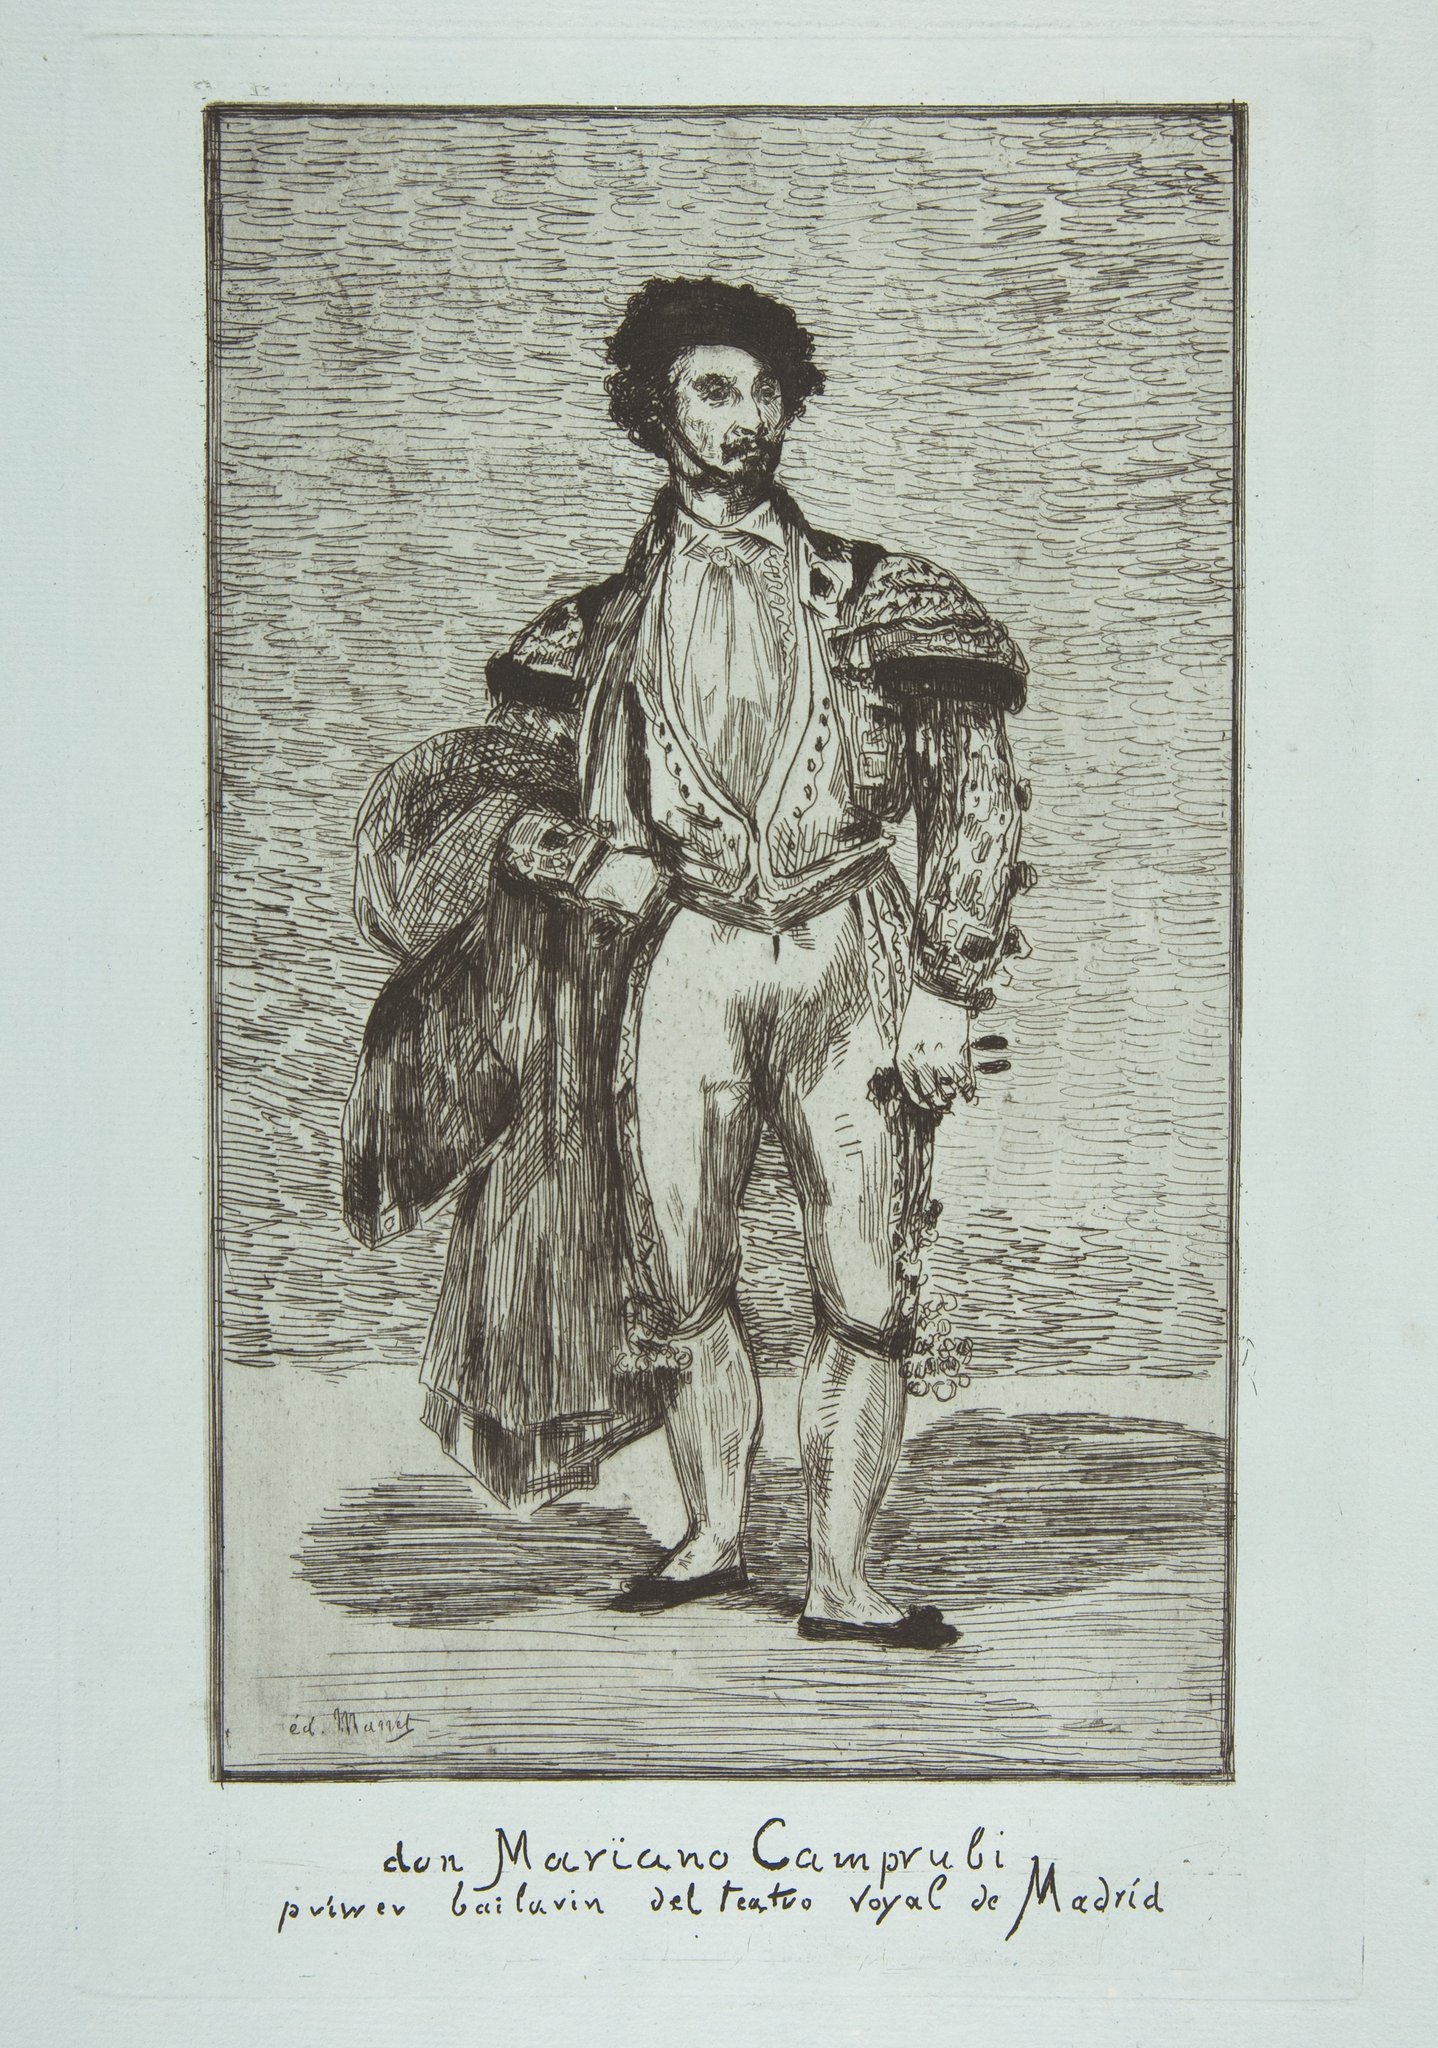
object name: print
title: Don Mariano Camprubi (Le Baïlarin)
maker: édouard manet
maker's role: artist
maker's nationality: french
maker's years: 1832-1883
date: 1862-1863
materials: paper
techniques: etching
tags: men